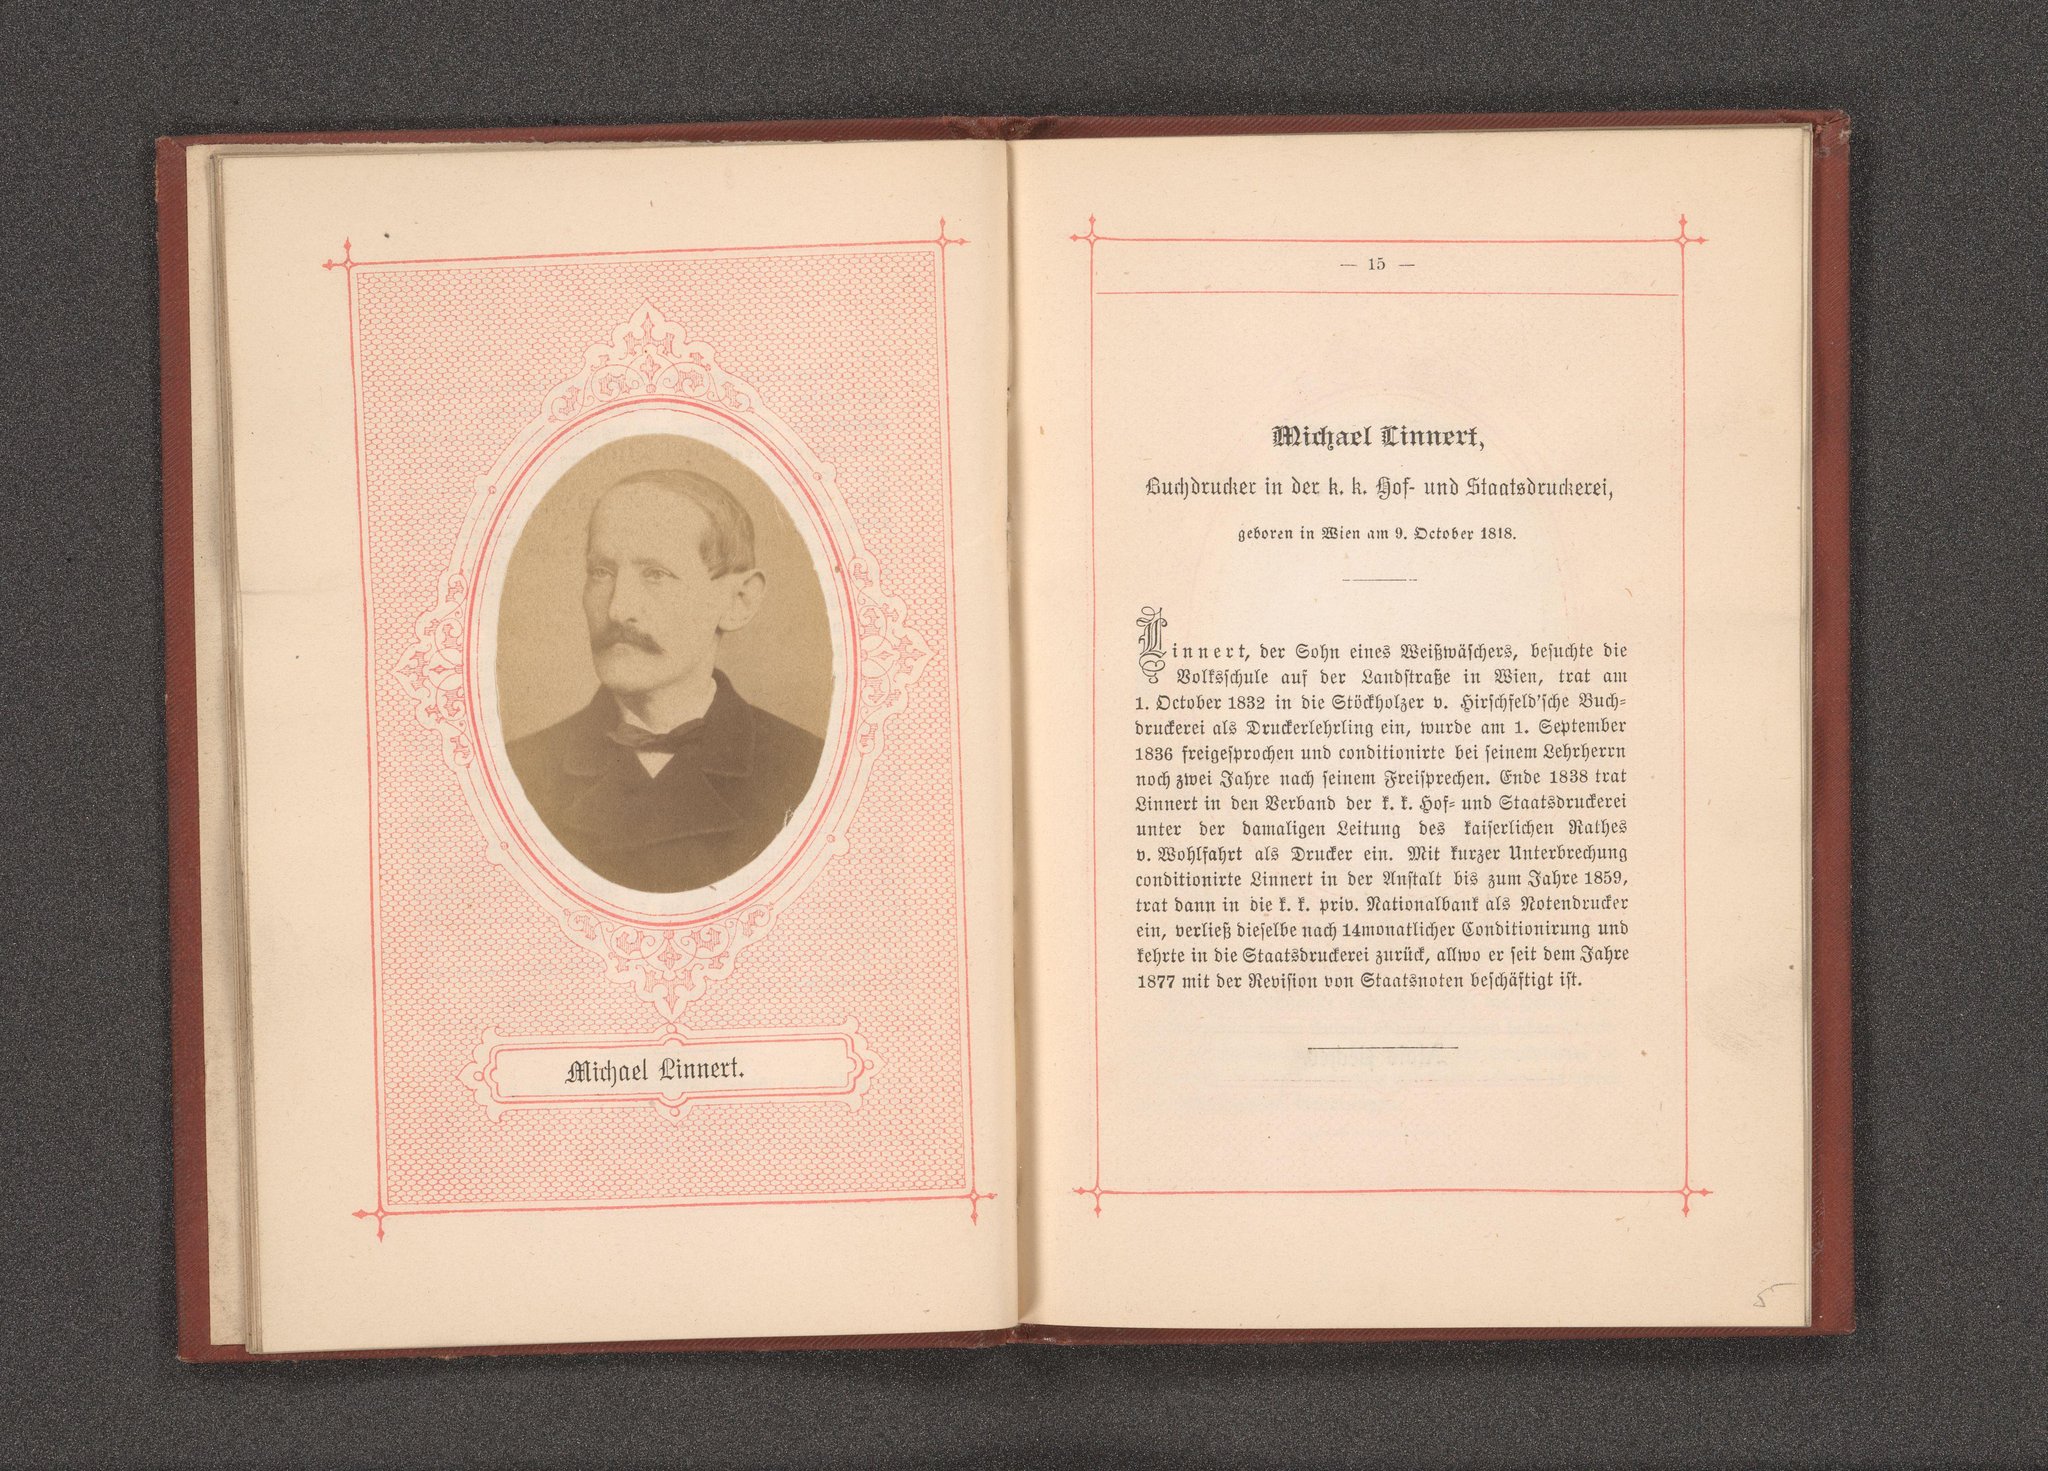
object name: page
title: Portret van Michael Linnert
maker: Anonymous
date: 1873-1883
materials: photographic support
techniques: albumen print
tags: printer